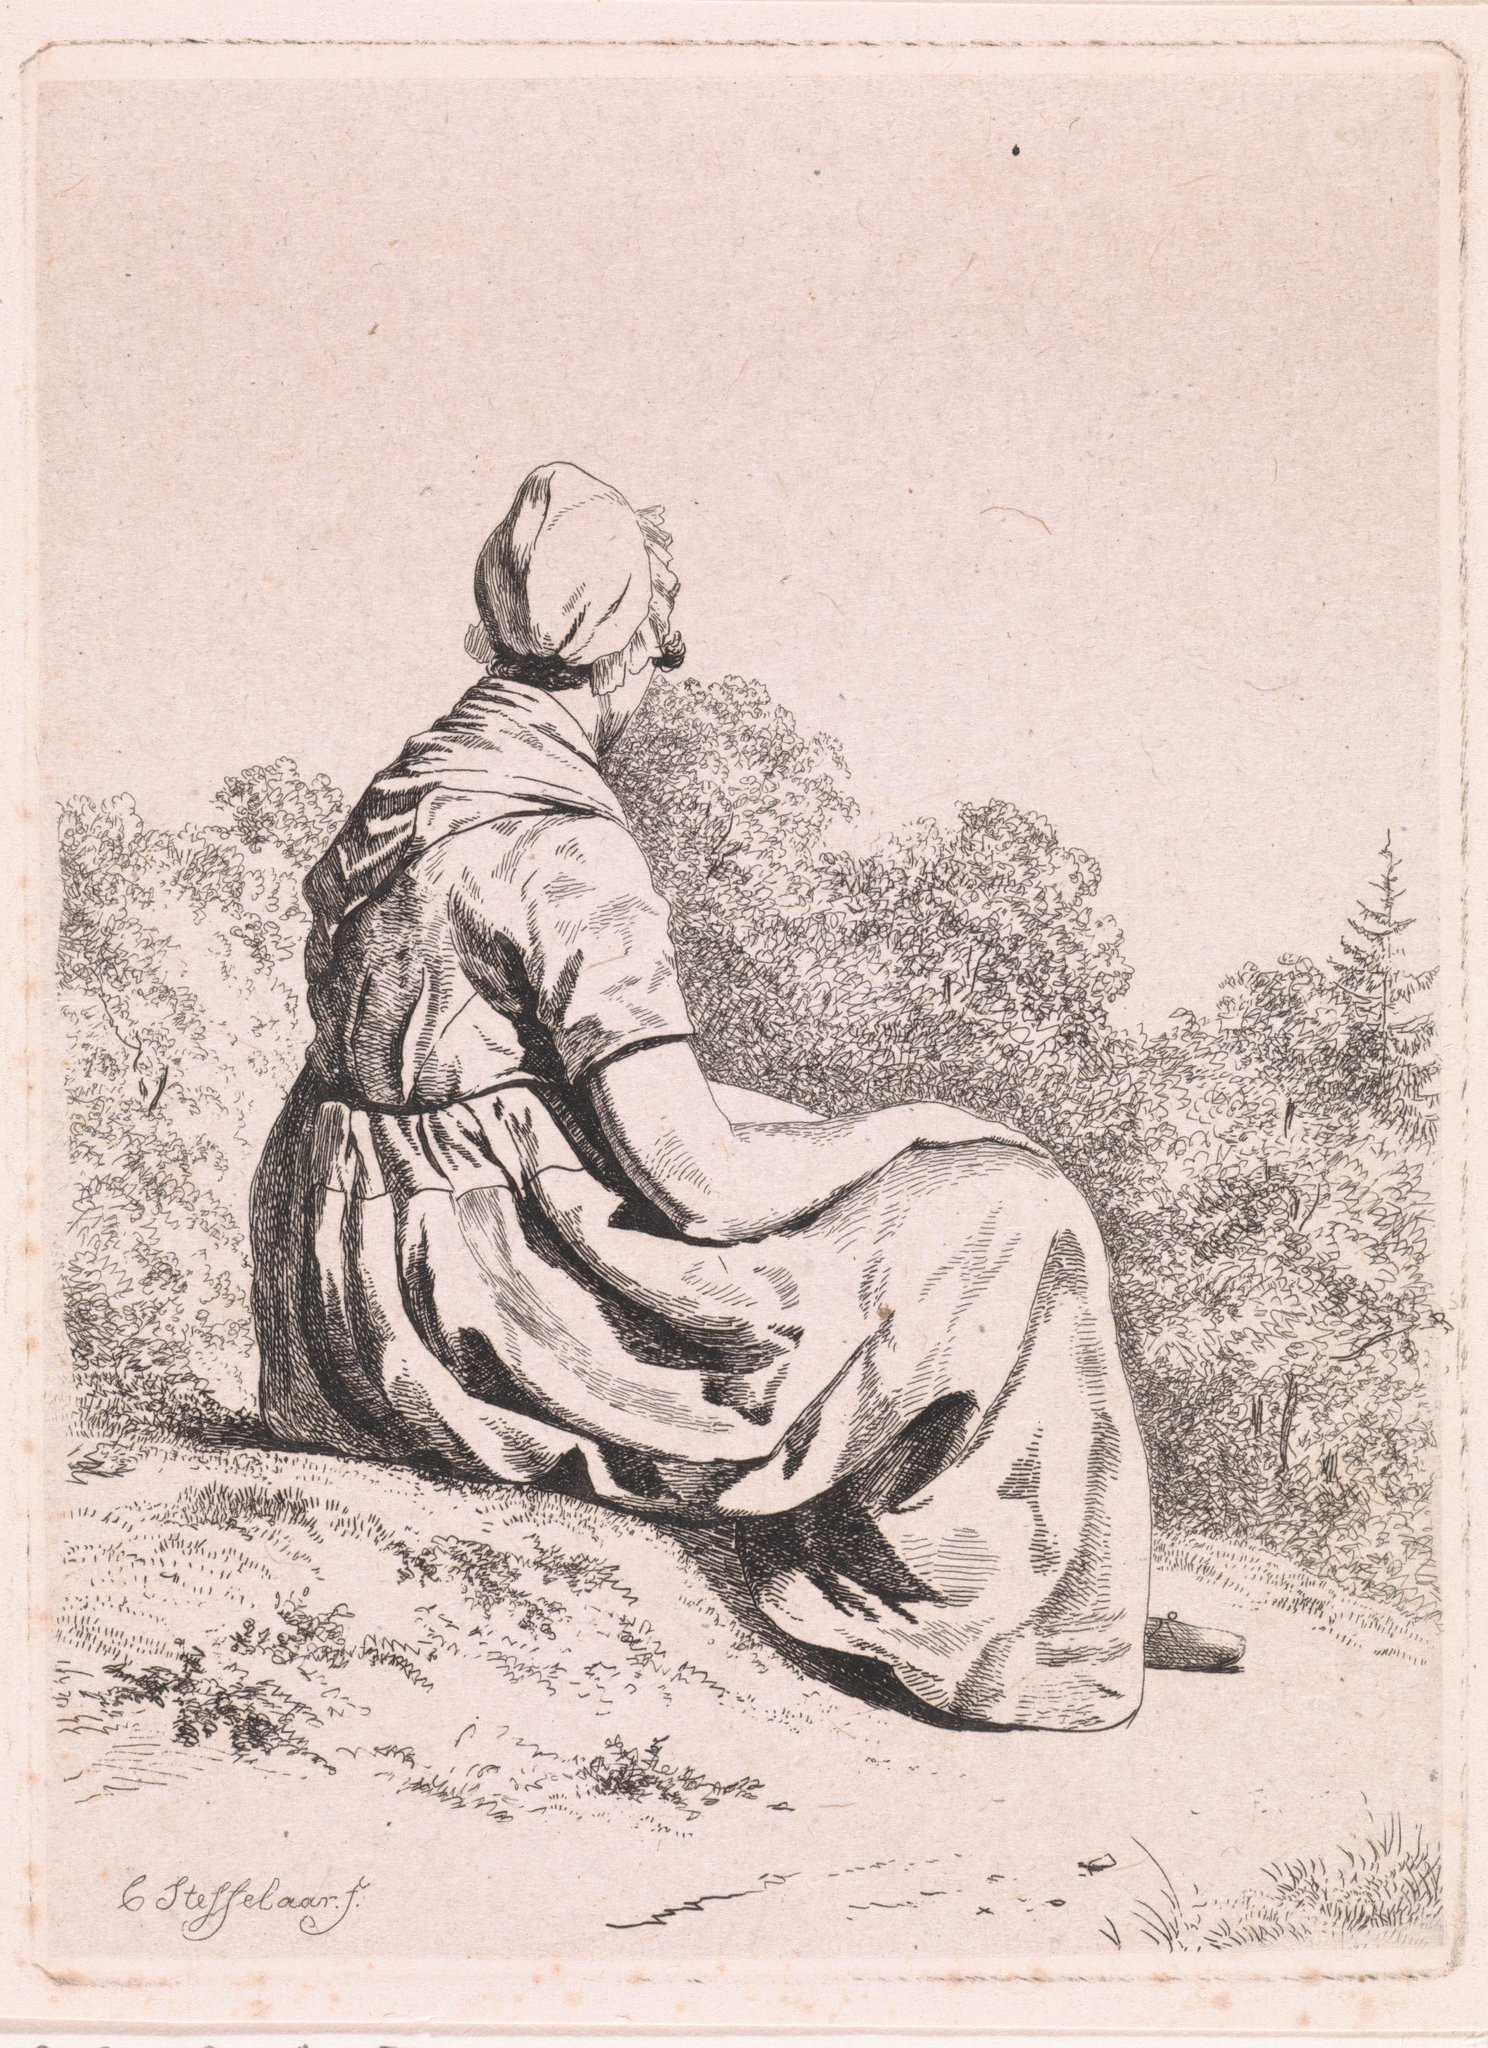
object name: print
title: Vierde suite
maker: cornelis steffelaar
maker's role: draughtsman, painter, print maker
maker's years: 1797-1861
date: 1807-1861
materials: paper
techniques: etching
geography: amsterdam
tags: sitting figure - aa - female human figure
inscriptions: collector's mark: Lugt 2228